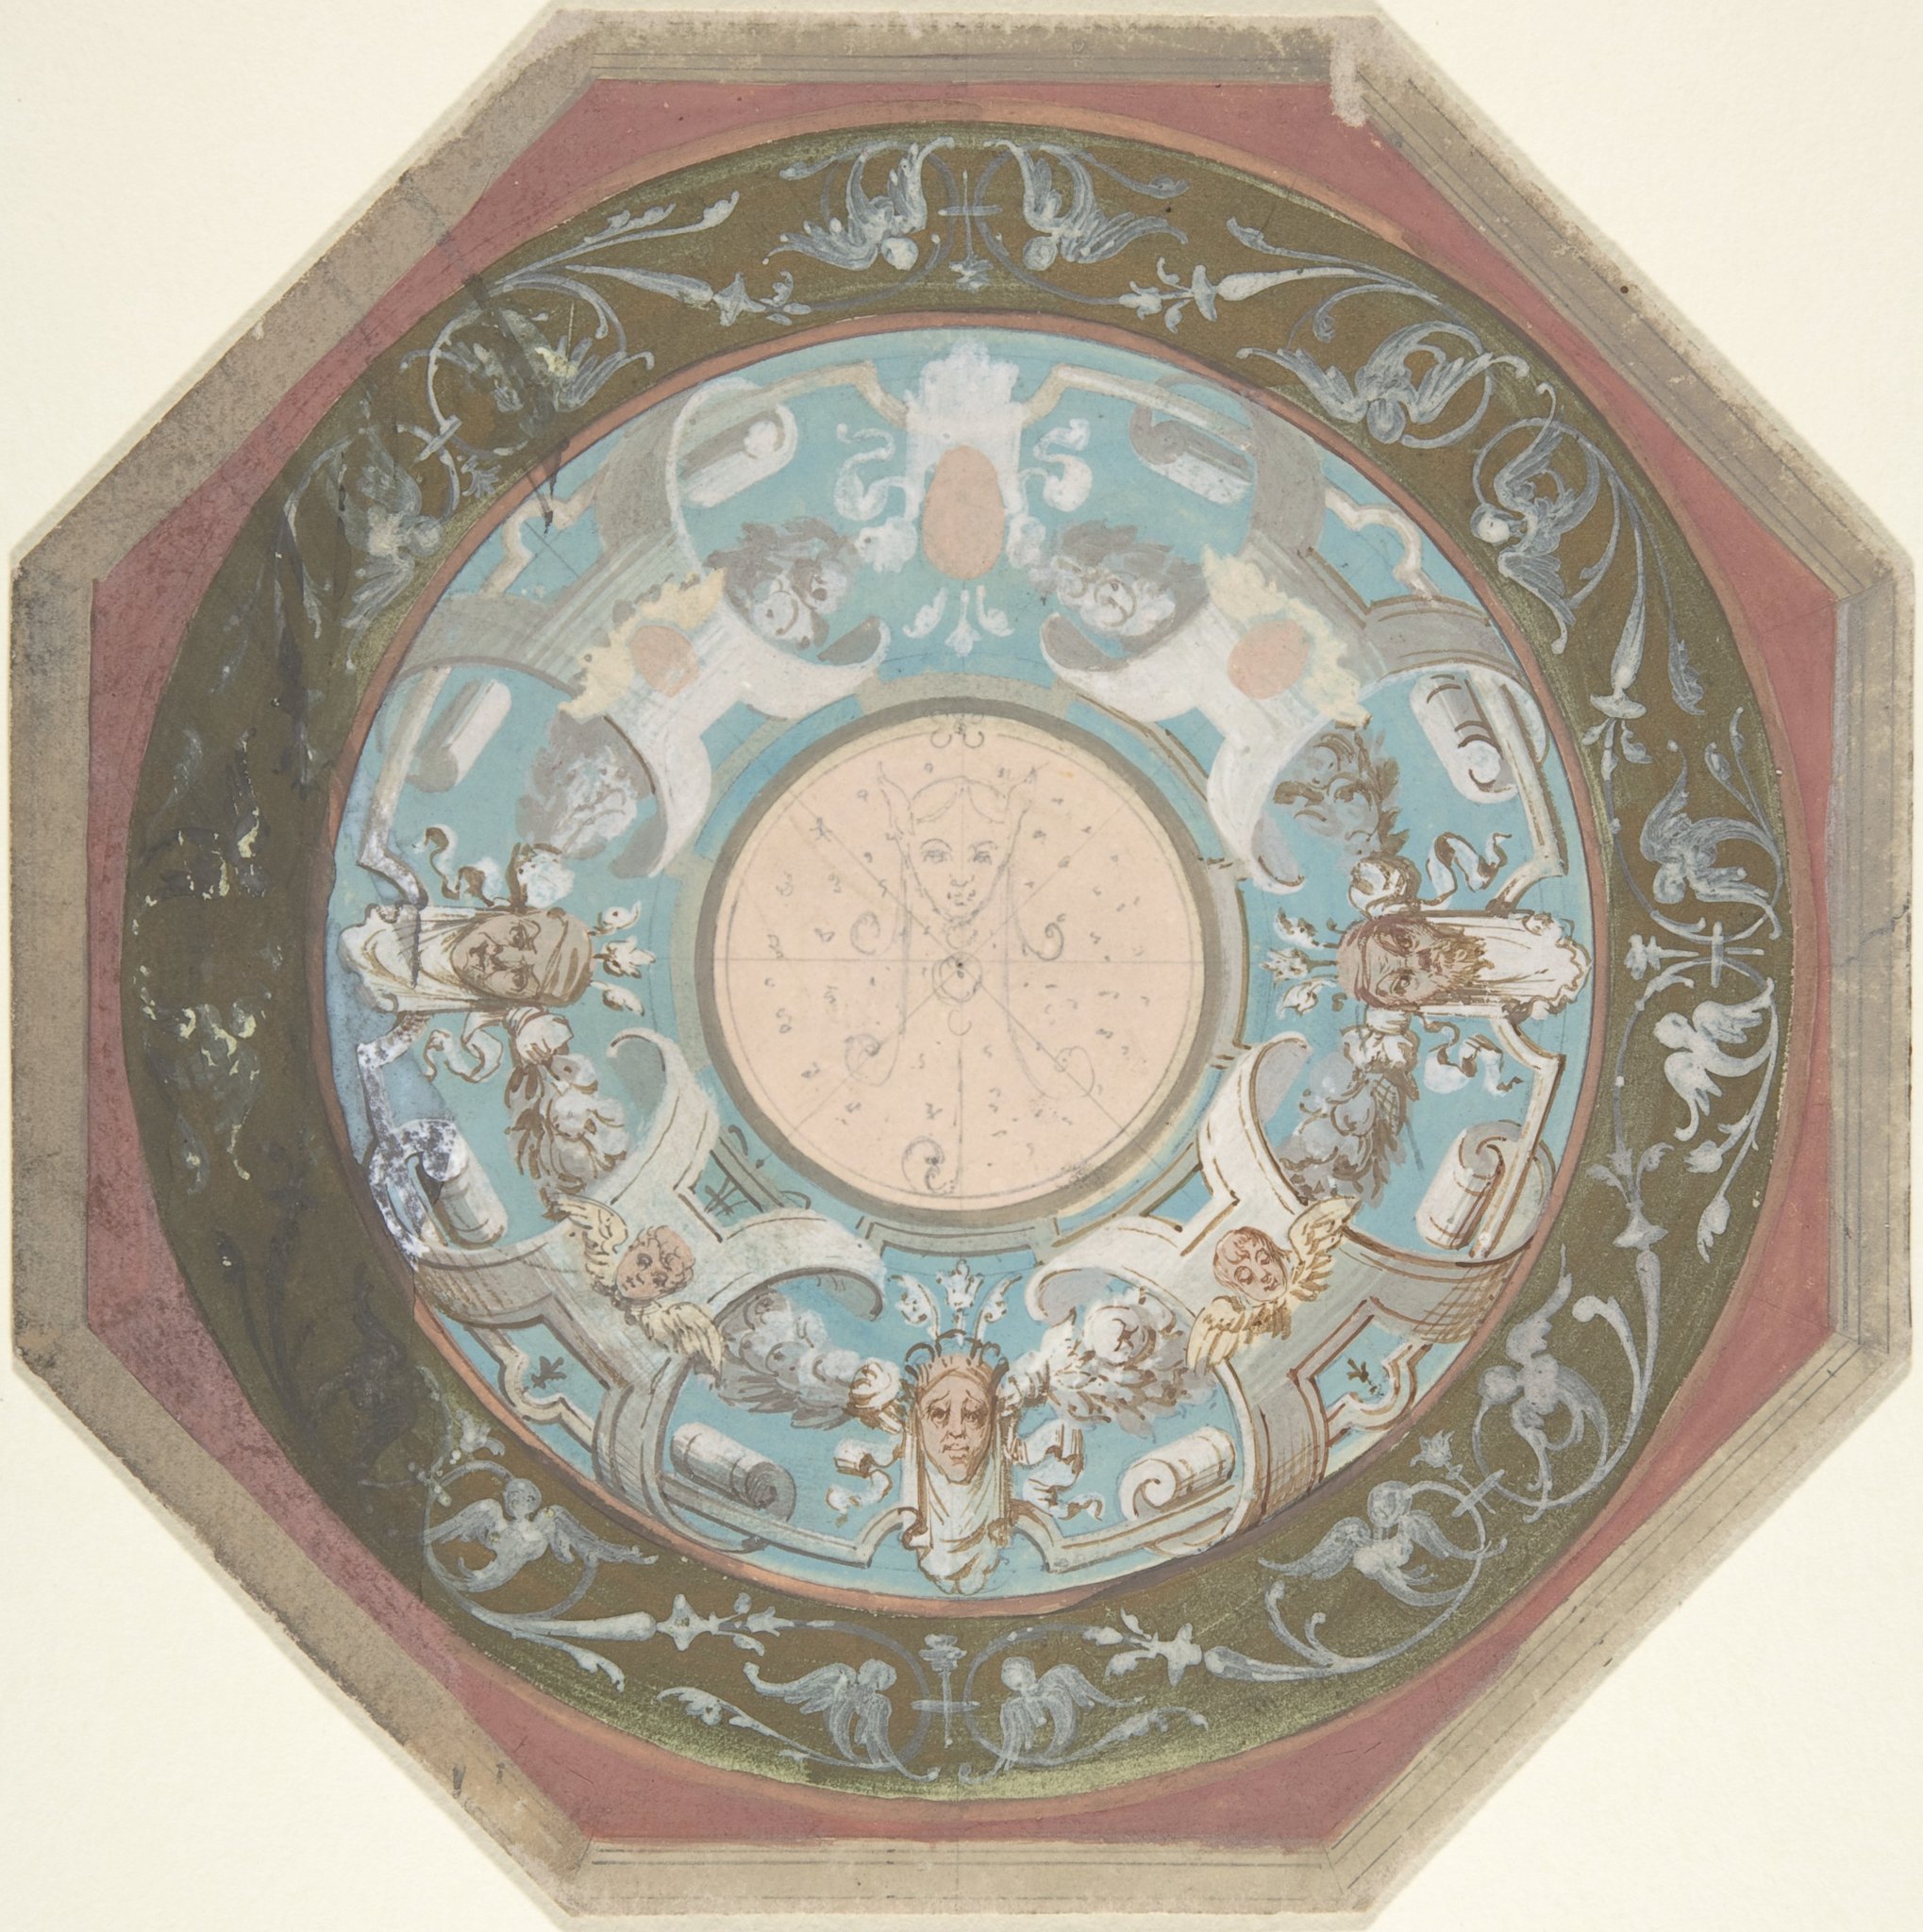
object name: drawing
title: Design for Octagonal Ceiling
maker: anonymous, british, 19th century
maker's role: artist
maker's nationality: british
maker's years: 1800-1900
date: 1801-1900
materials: gold, watercolor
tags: ceilings